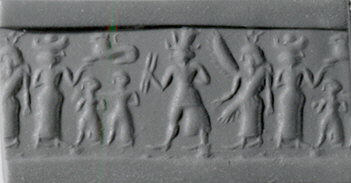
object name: cylinder seal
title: Cylinder seal and modern impression: war goddess flanked by goddesses with Egyptian-style sun-disk headdress and vertical wings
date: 1720-1650 BCE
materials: mineral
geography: syria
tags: goddess